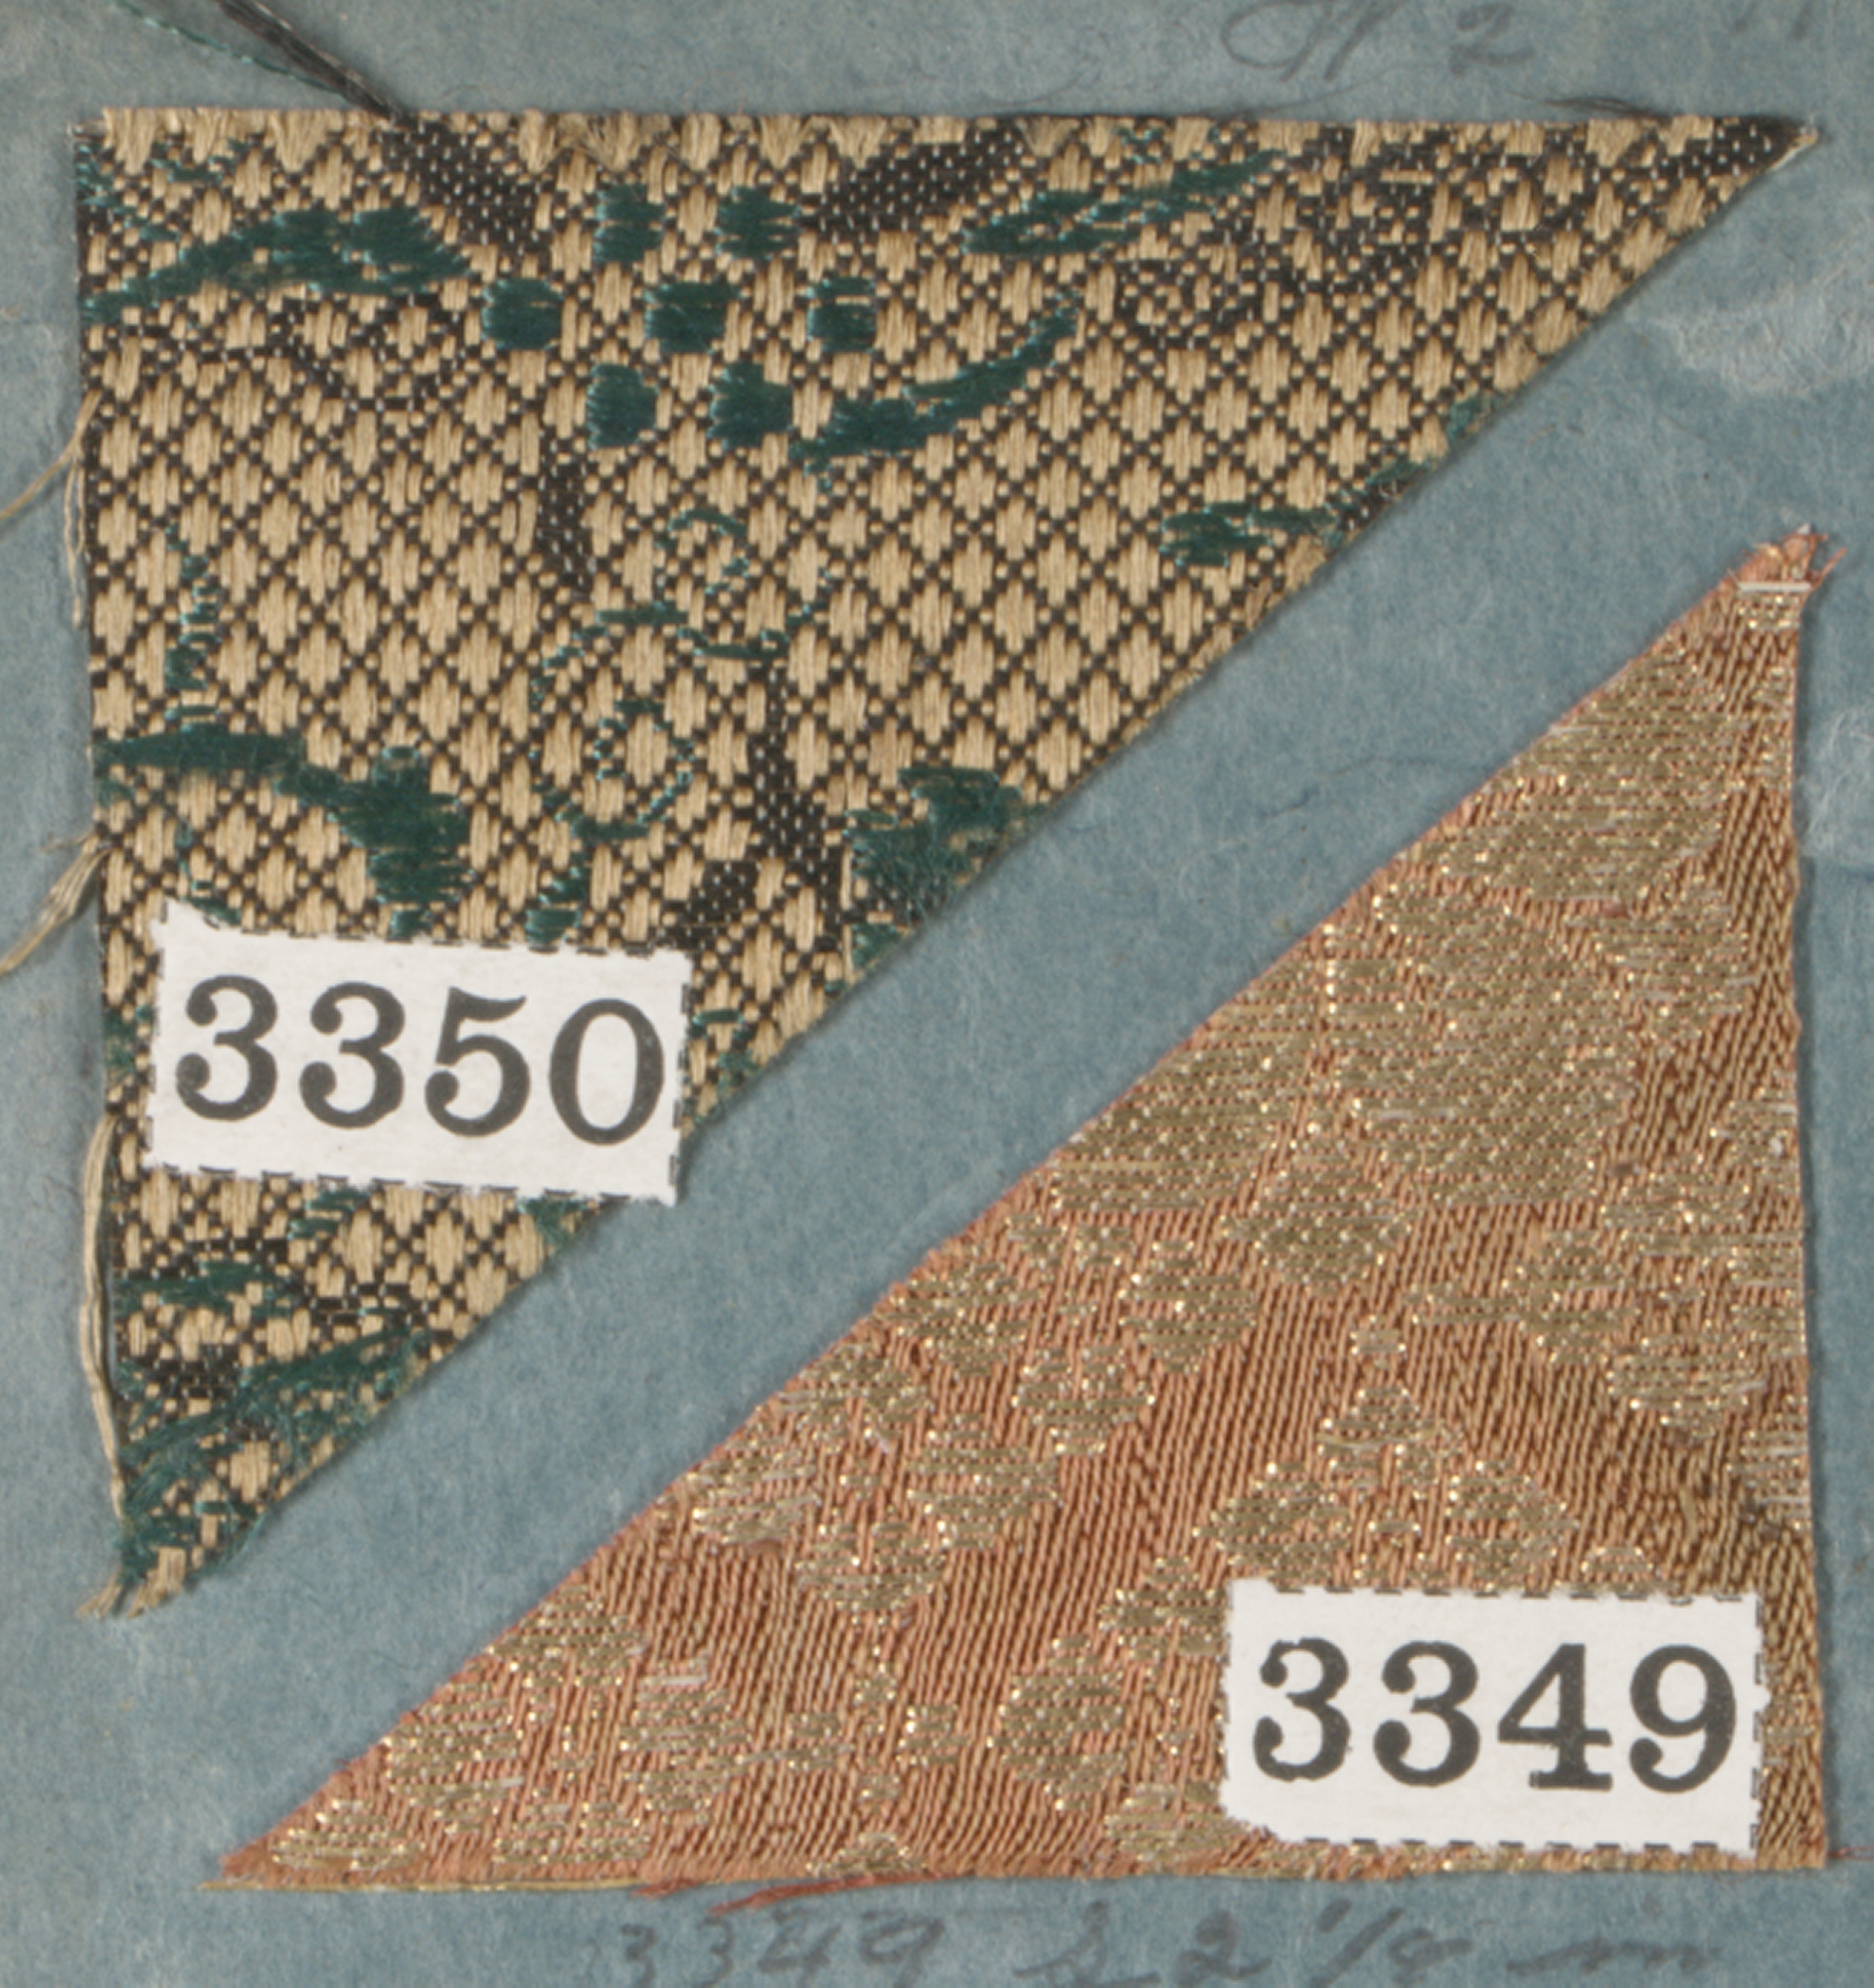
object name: textile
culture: japanese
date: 1801-1900